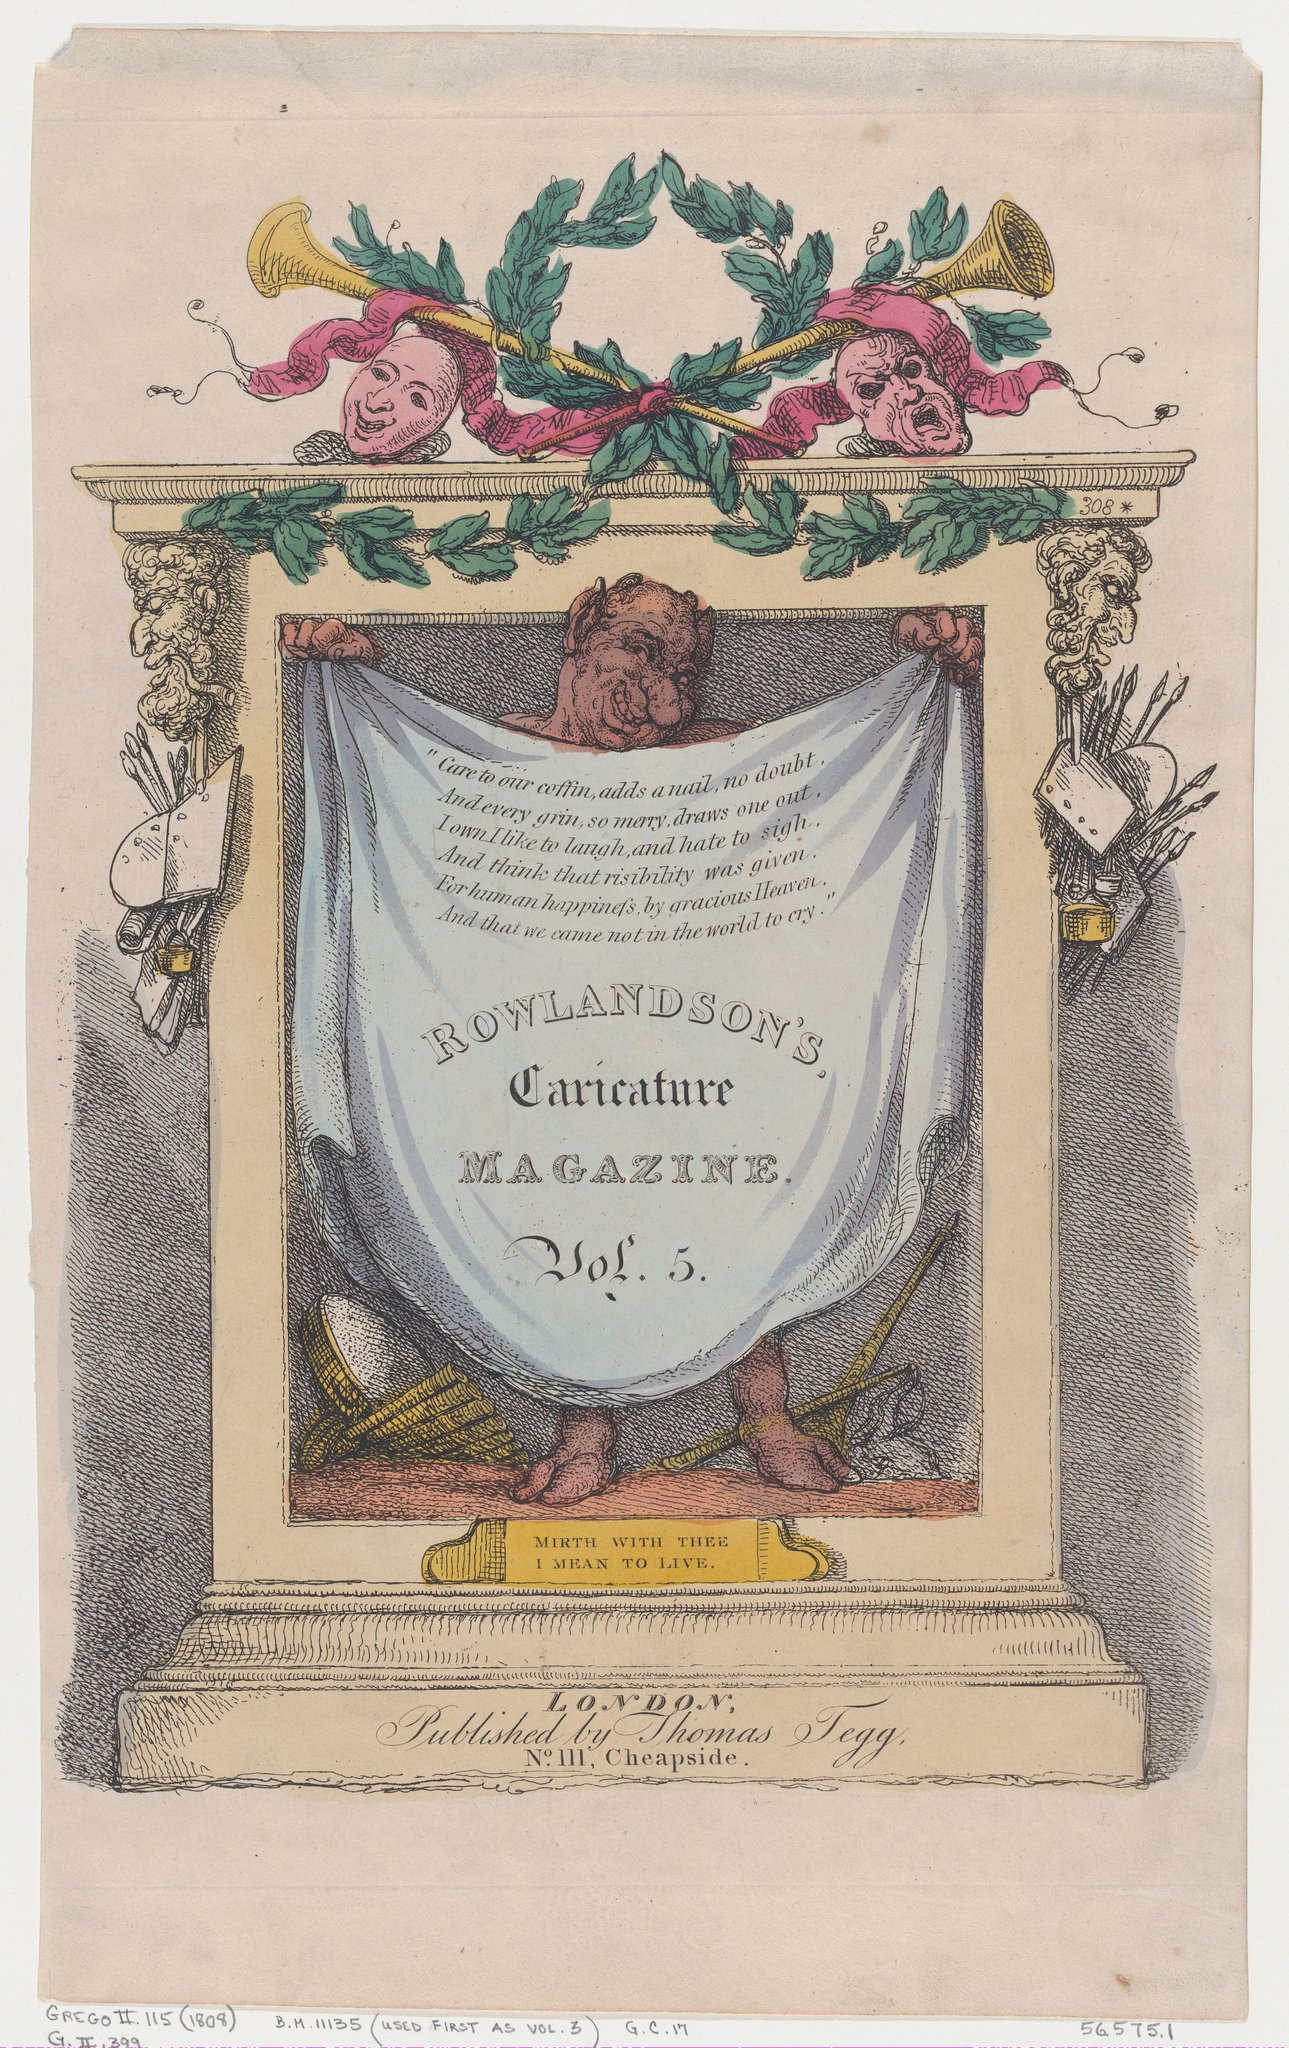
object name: print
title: Title Page, Rowlandson's Caricature Magazine, Vol. 5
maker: thomas rowlandson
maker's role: artist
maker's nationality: british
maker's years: 1757-1827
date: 1808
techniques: etching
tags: satyrs,caricature